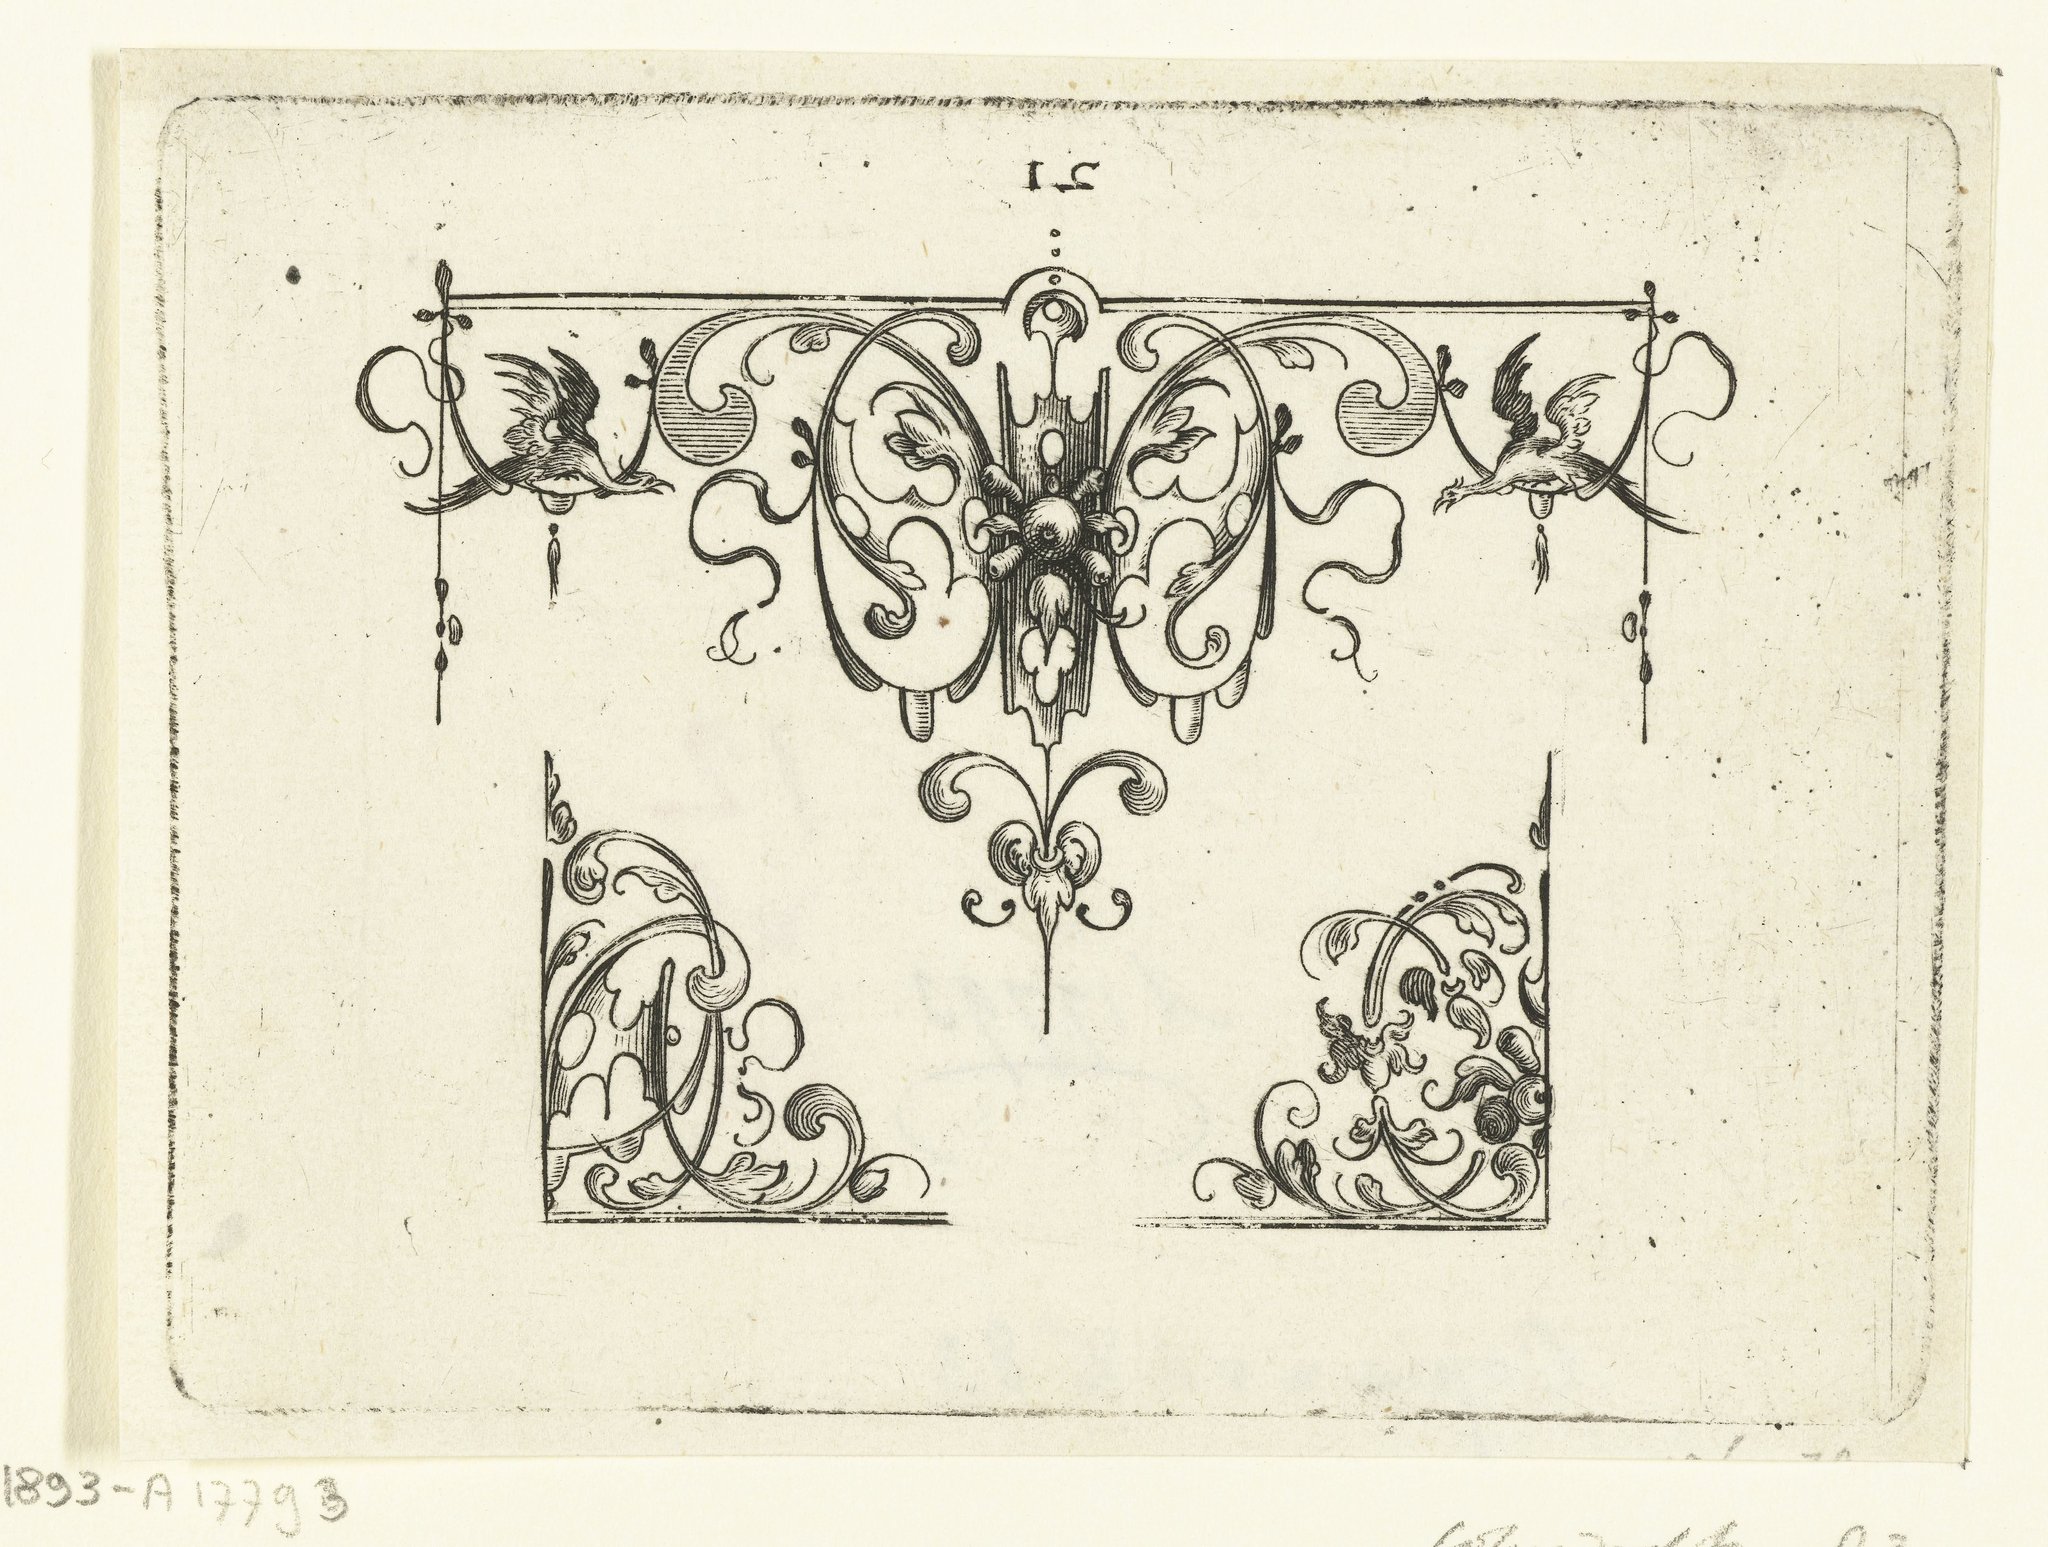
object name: ornament print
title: Spits met linksboven en rechtsboven een vogel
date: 1611-1635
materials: paper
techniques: engraving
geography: nuremberg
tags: fantasy ornament, birds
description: Kopie van serie met dezelfde titel, uitgegeven door Michiel le Blon. Blad 12 uit serie van 14 bladen met voorbeelden voor gegraveerde decoratieranden van bekers in de vorm van driehoeken bestaande uit ranken, Schweifwerk, guirlandes met putti, dieren, vogels en maskers